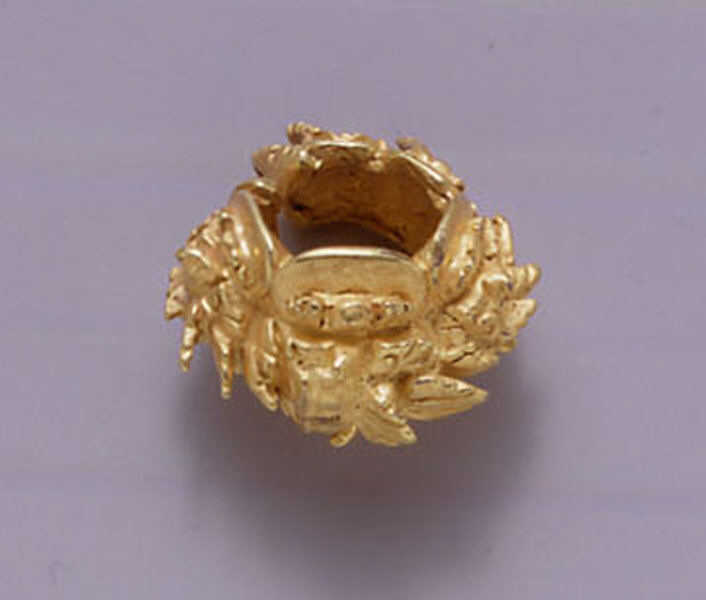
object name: ear ornament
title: Ear Ornament with Makara Motif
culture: indonesian, javanese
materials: gold